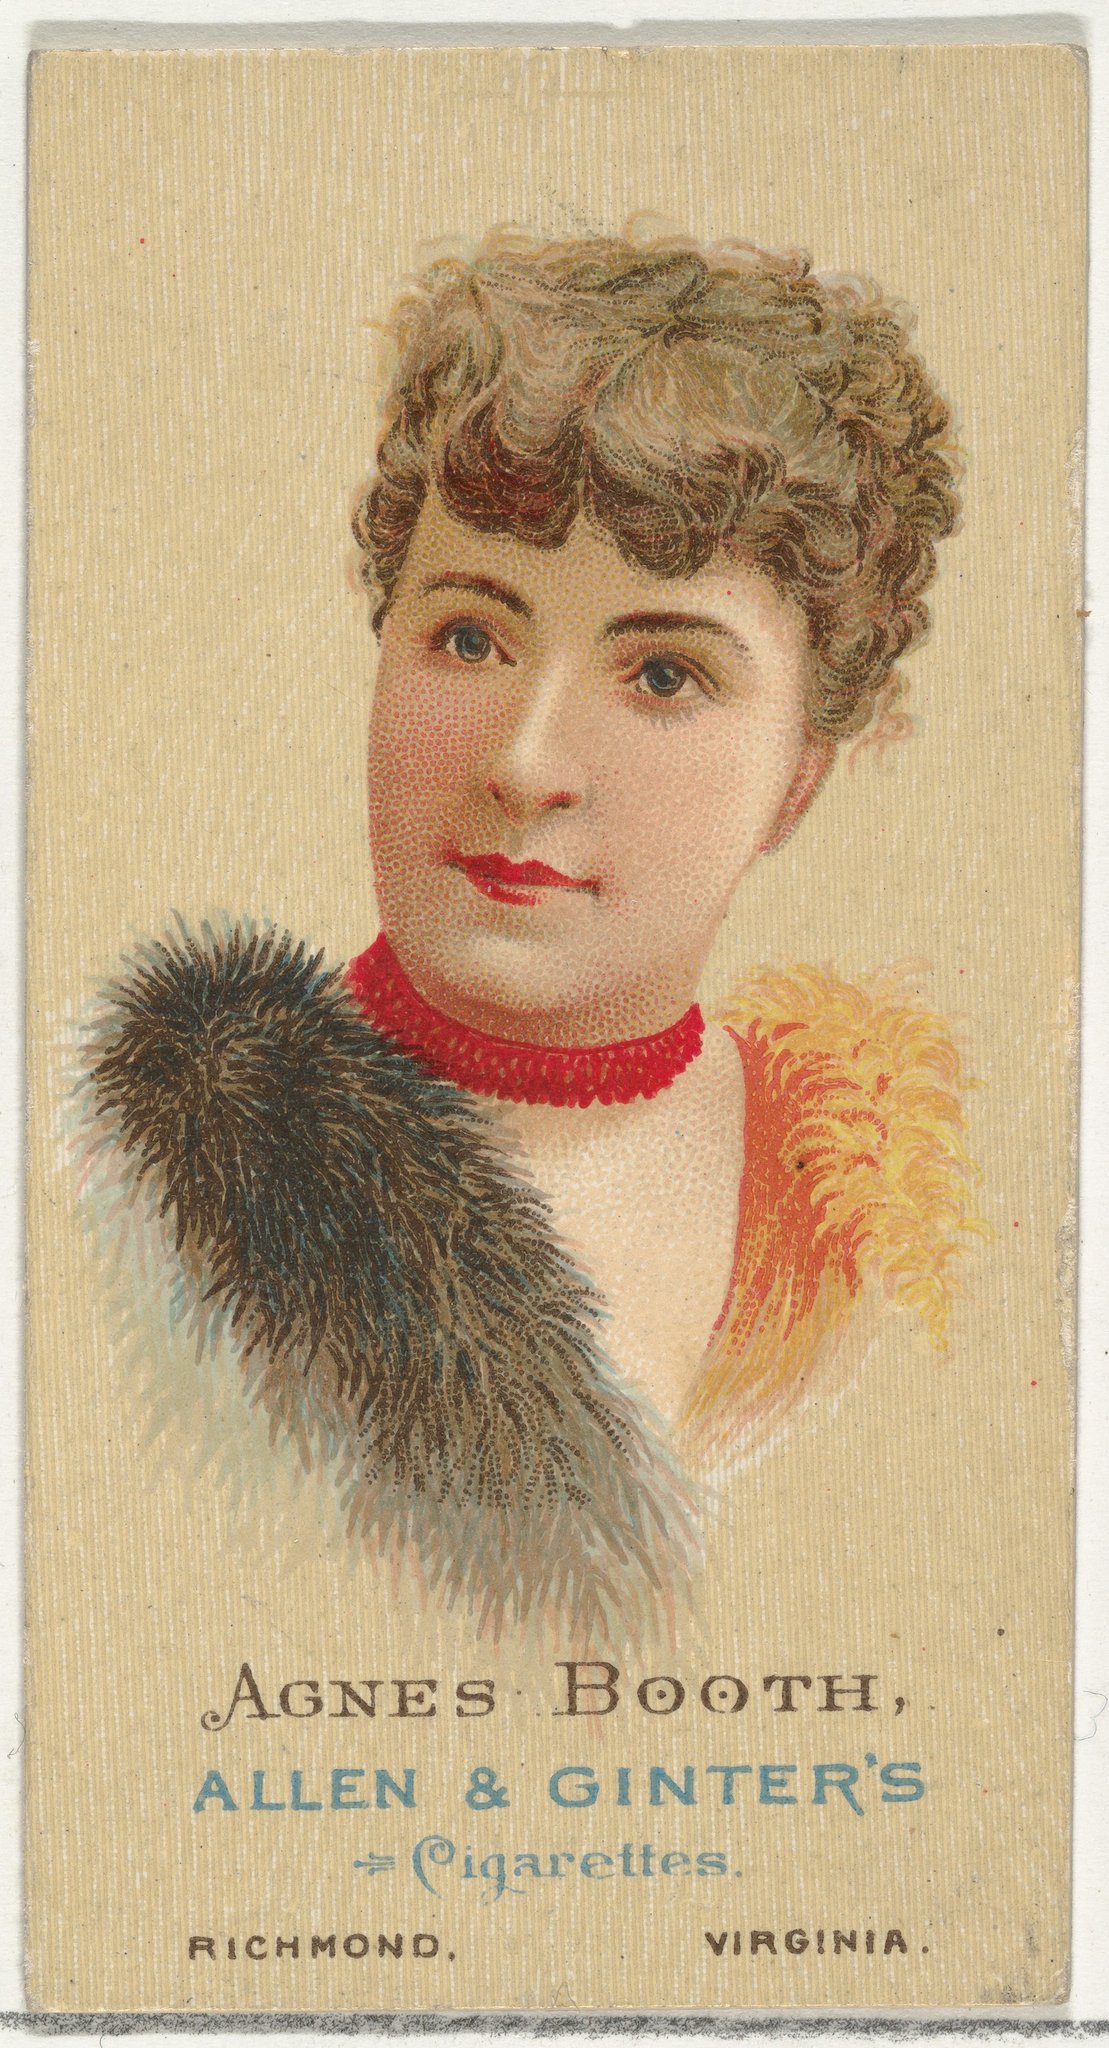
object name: print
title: Agnes Booth, from World's Beauties, Series 2 (N27) for Allen & Ginter Cigarettes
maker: allen & ginter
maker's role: publisher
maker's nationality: american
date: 1888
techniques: color lithograph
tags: women